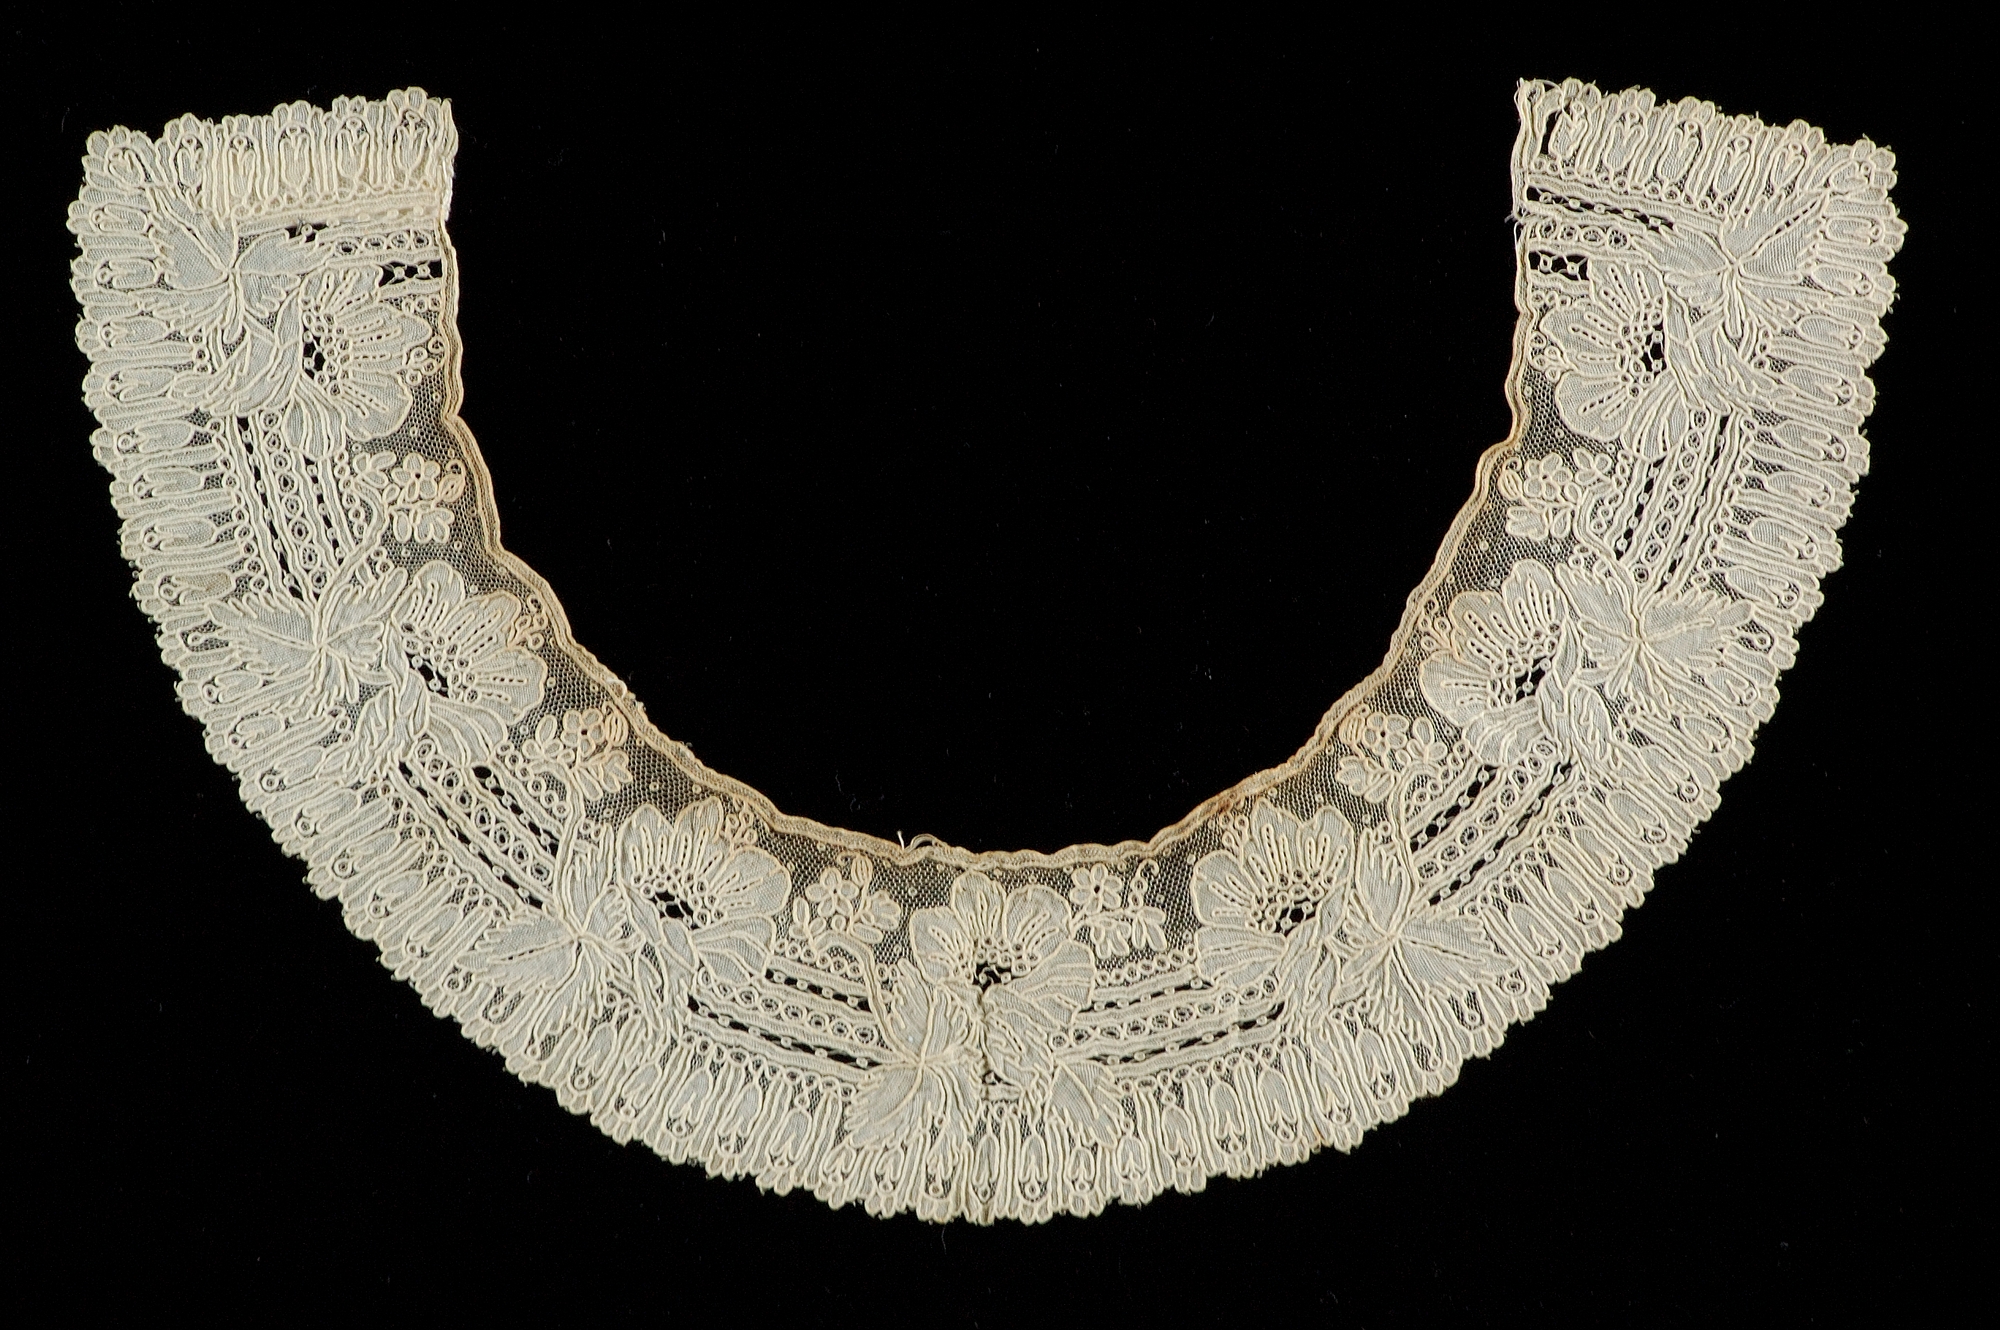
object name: collar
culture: belgian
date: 1855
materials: linen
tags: flowers